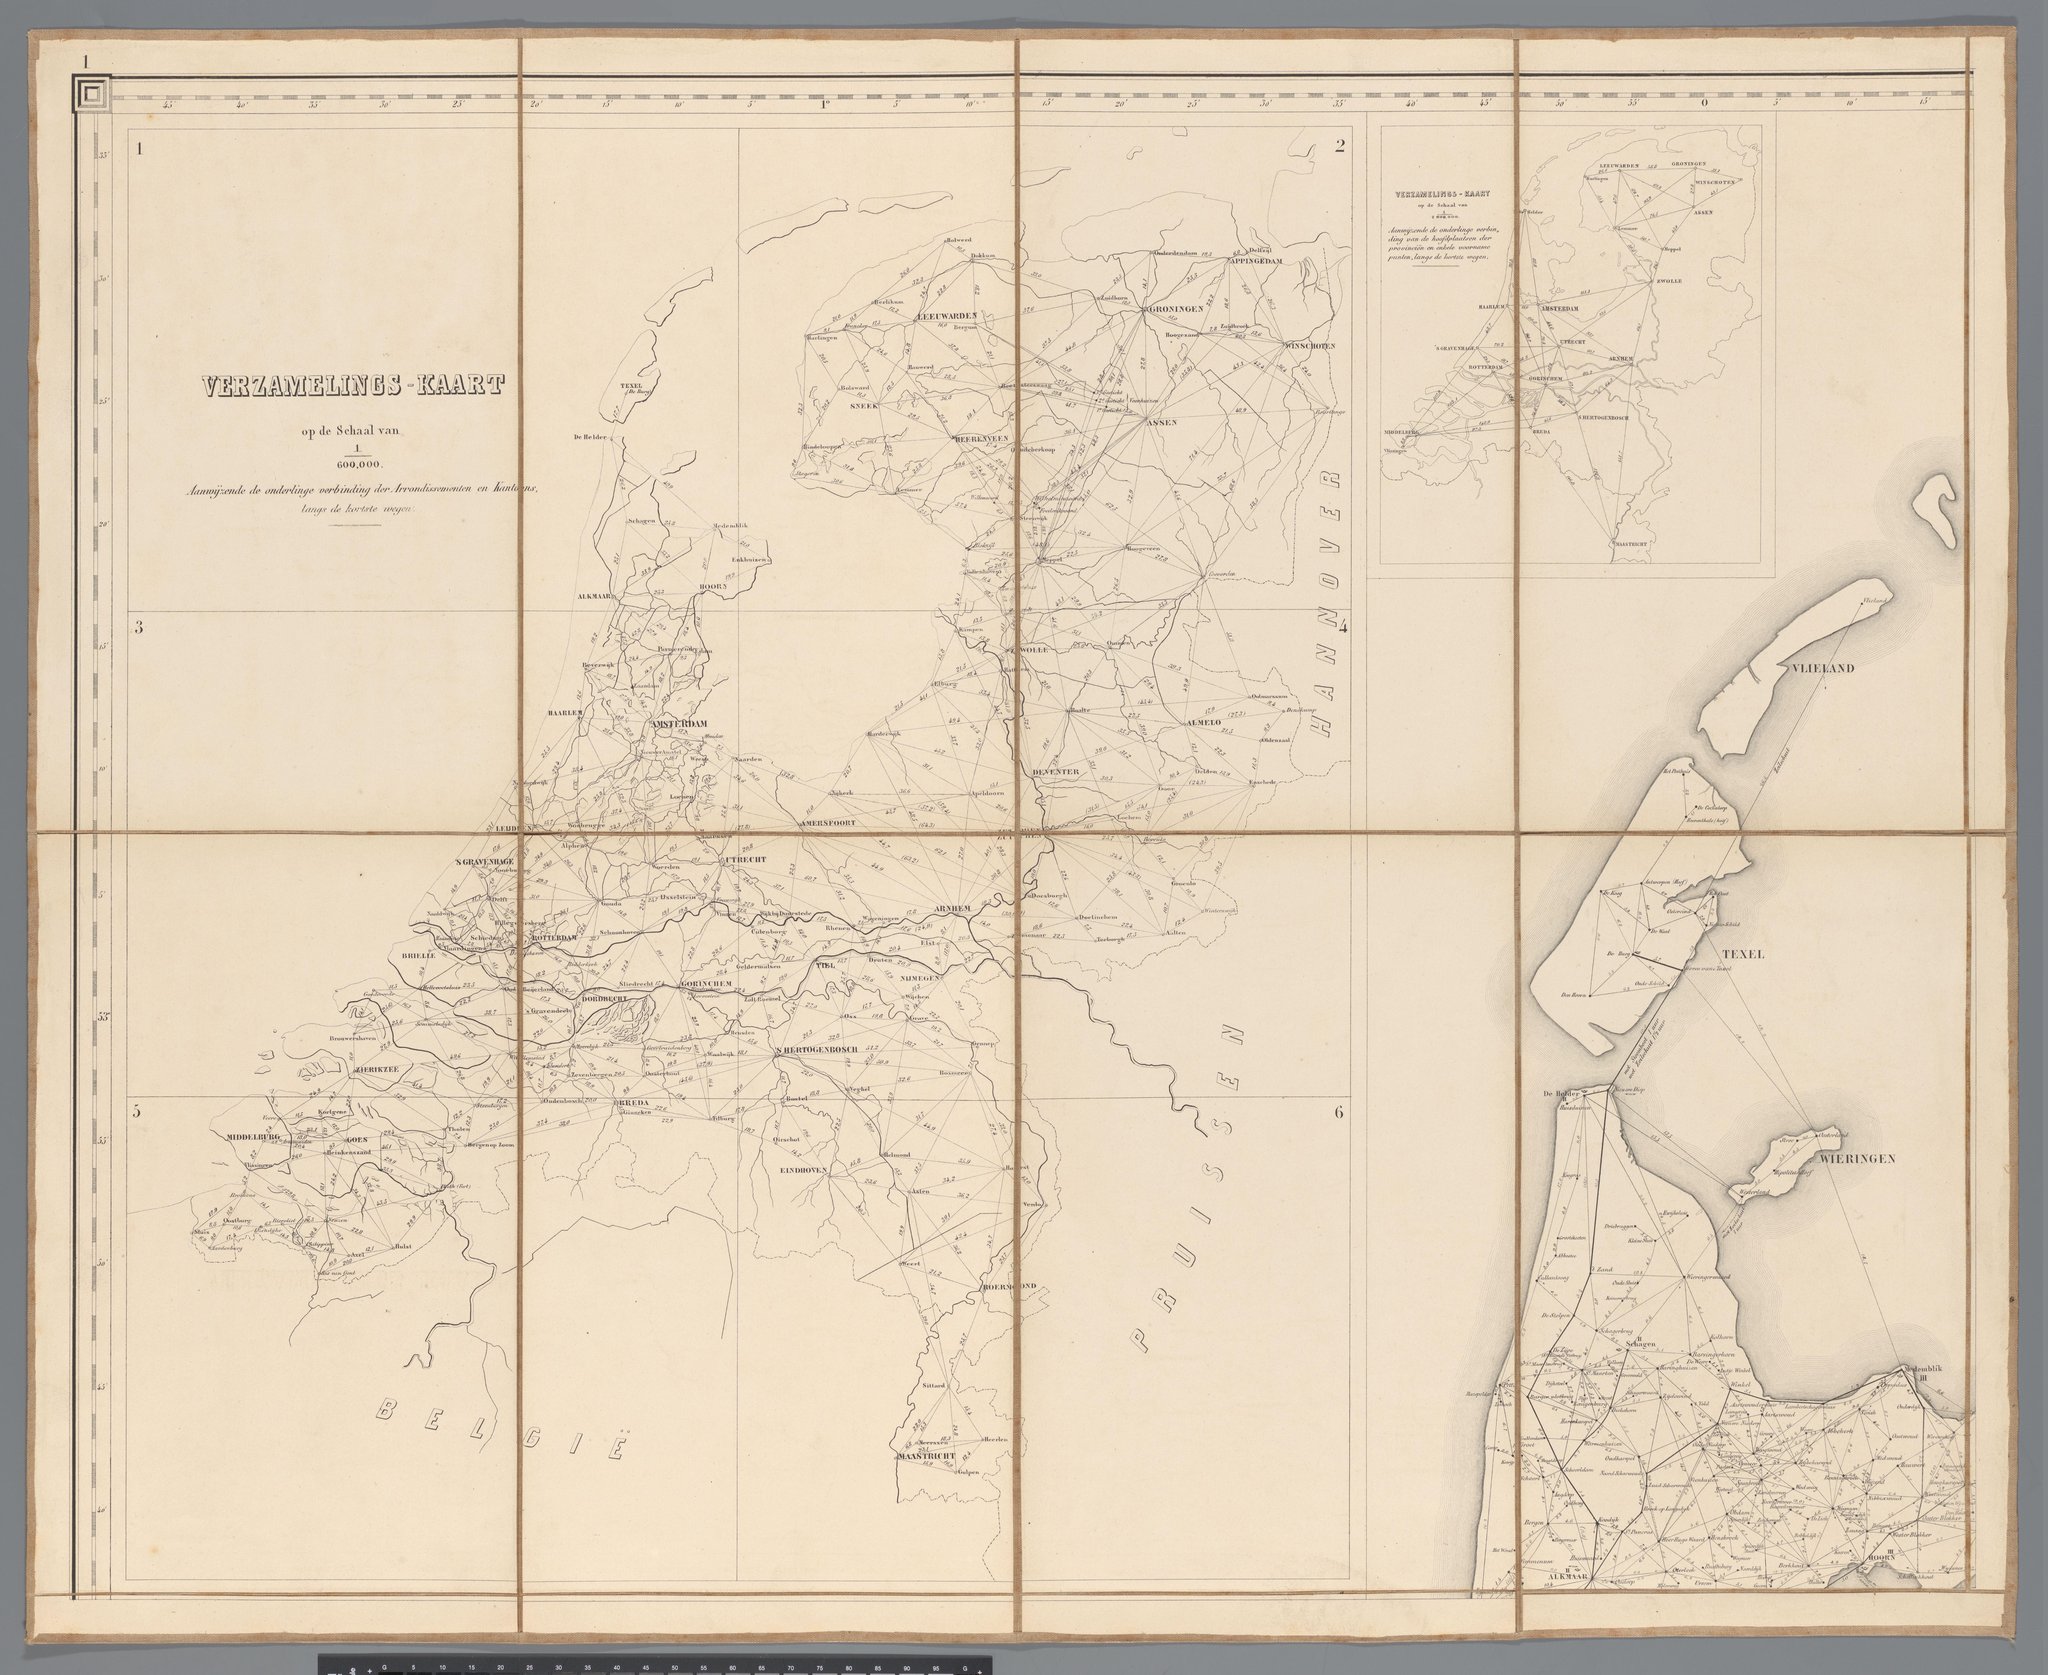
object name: map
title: Afstands-wijzer van het Koningrijk der Nederlanden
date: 1862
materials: linen, paper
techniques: lithograph, printing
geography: the hague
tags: netherlands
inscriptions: date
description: Eén van zes kaartenbladen met legenda (zie NG-934-1 t/m 6), op linnen geplakt, in kartonnen doos, buiten met zwart kunstleer beplakt en aan de binnenkant met groen-zwart ruitjespapier. Gedateerd; blad 3, l.b.: 1862.